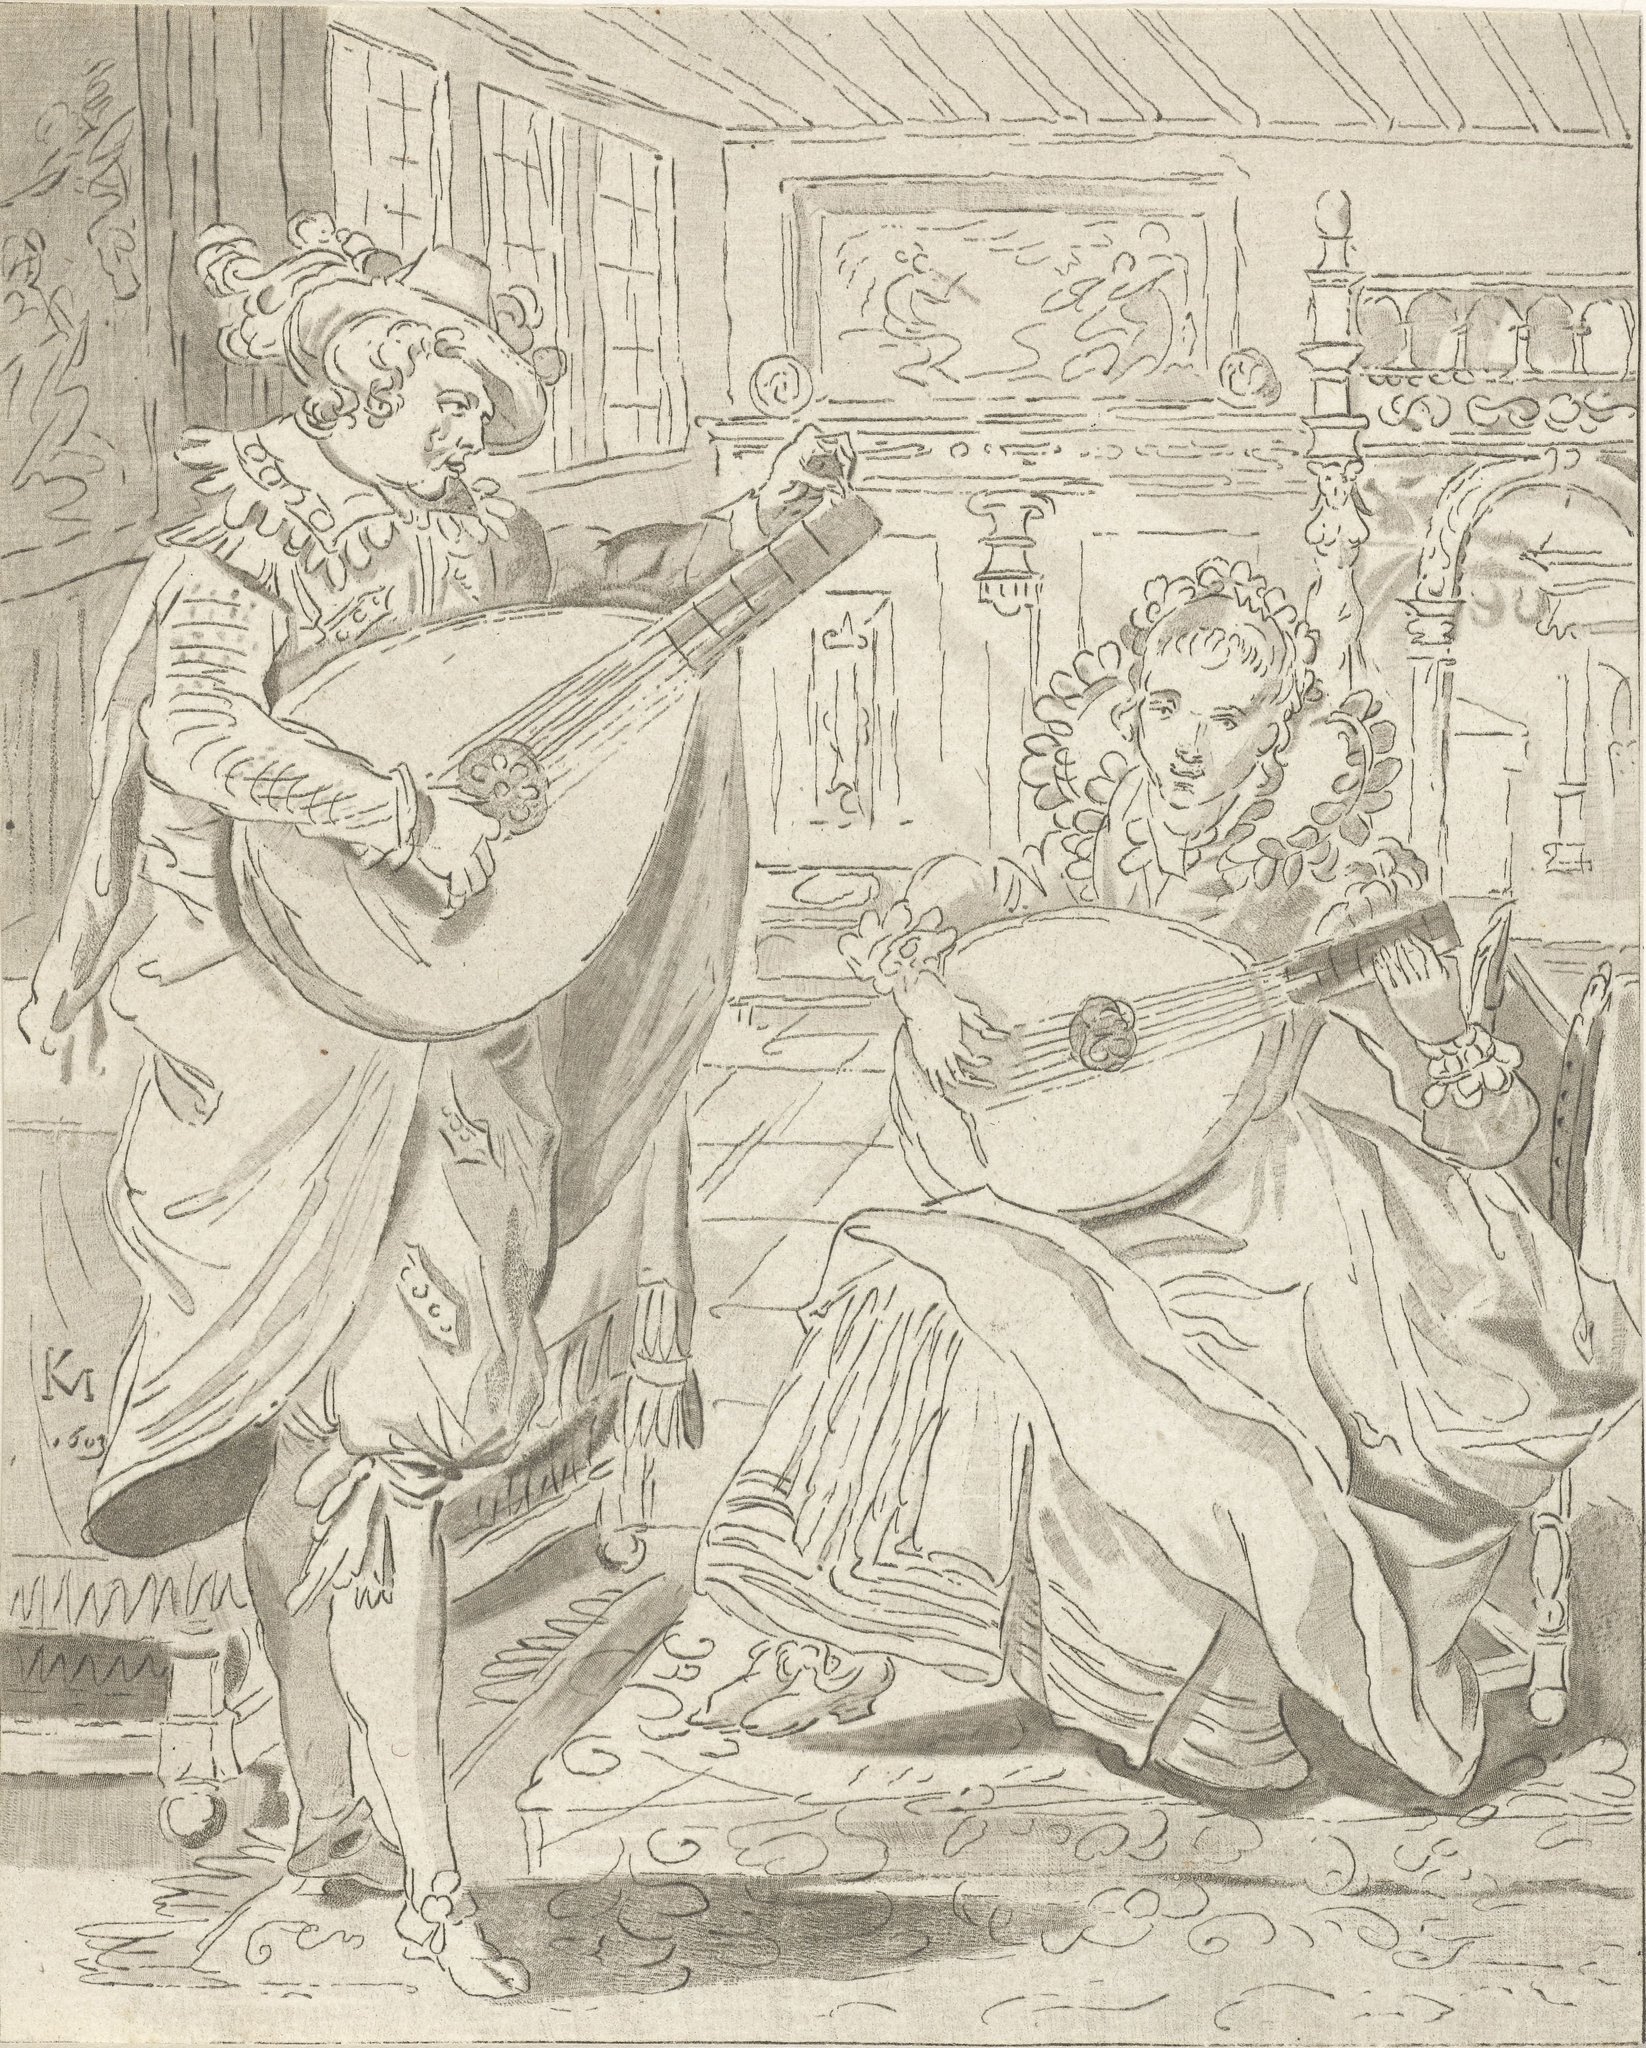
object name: print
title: Luitspelende heer en dame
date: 1772-1774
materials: paper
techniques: etching, hand coloring, roulette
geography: amsterdam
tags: interior of the house, lute, and special forms of lute, e.g.: theorbo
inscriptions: collector's mark: Lugt 2725, collector's mark: Lugt 240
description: Interieur met een man en een vrouw, die allebei de luit bespelen.